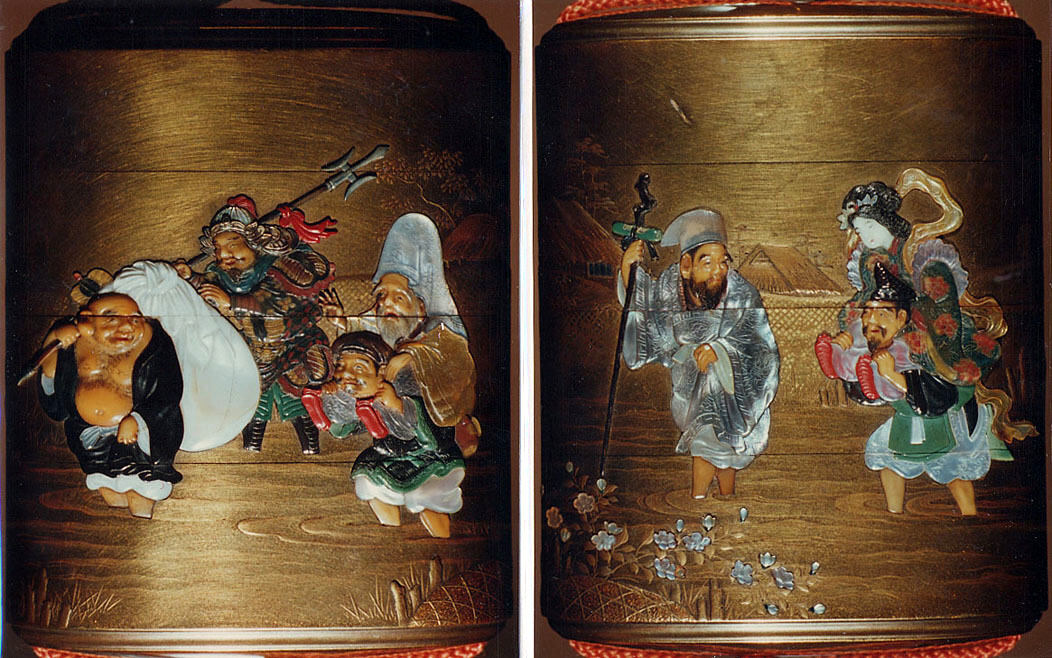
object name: inrō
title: Case (Inrō) with Design of the Seven Gods of Good Fortune Fording a River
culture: japanese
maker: nakayama komin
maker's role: artist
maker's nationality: japanese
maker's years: 1808-1870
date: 1867-1900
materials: gold, ivory, lacquer, mother of pearl, wood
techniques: fundame, inlay, polish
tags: men,women,gods